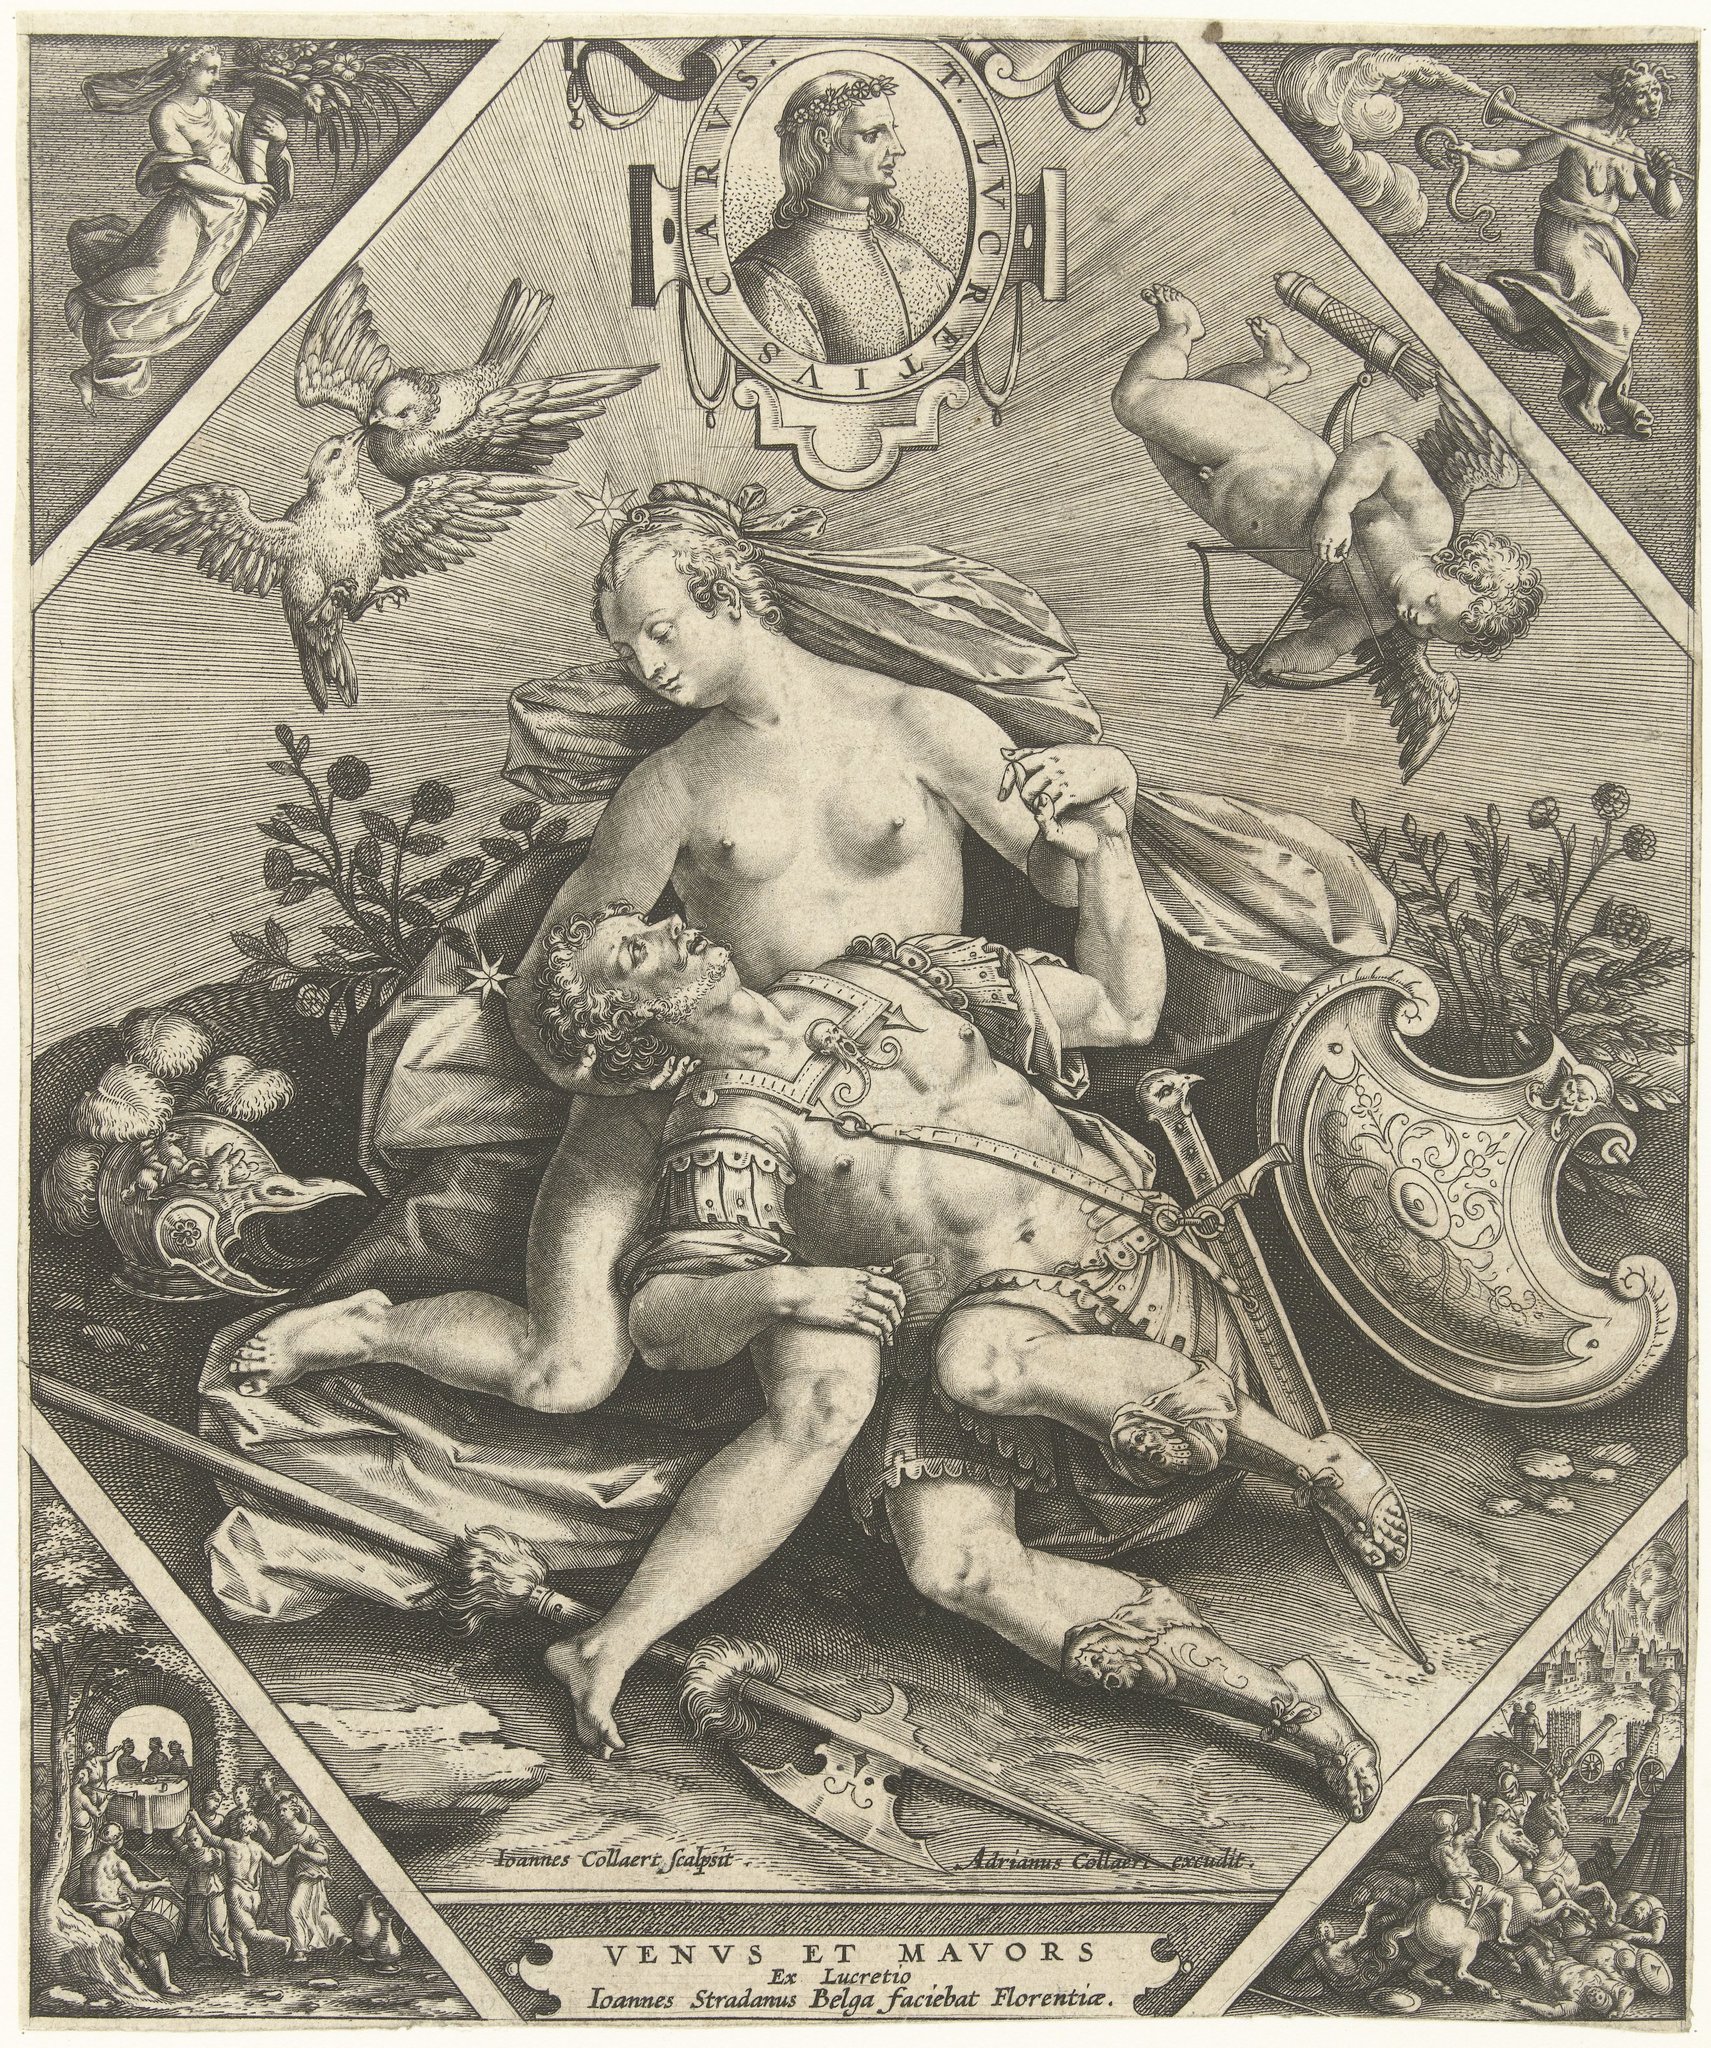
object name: print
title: Venvs et Mavors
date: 1576-1628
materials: paper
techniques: engraving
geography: antwerp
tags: titus lucretius, mars and venus as lovers, envy; 'invidia' (ripa) ~ personification of one of the seven deadly sins, wealth, opulence; 'opulenza', 'richezza' (ripa), (story of) cupid, amor (eros), war, other birds: turtle dove, festivities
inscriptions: collector's mark: Lugt 2228, collector's mark: Lugt 2760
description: Mars, gekleed als soldaat, ligt in de armen van een naakte Venus. In de lucht vliegen twee tortelduiven en Cupido, pijl en boog in aanslag. Bovenaan de prent in een ovaal kader het portret van de Romeinse dichter Lucretius. Boven in de hoeken: links de personificatie van Overvloed, rechts de personificatie van Wreedheid. Onder in de hoeken: links een feest, rechts de oorlog. De prent heeft een Latijns onderschrift.